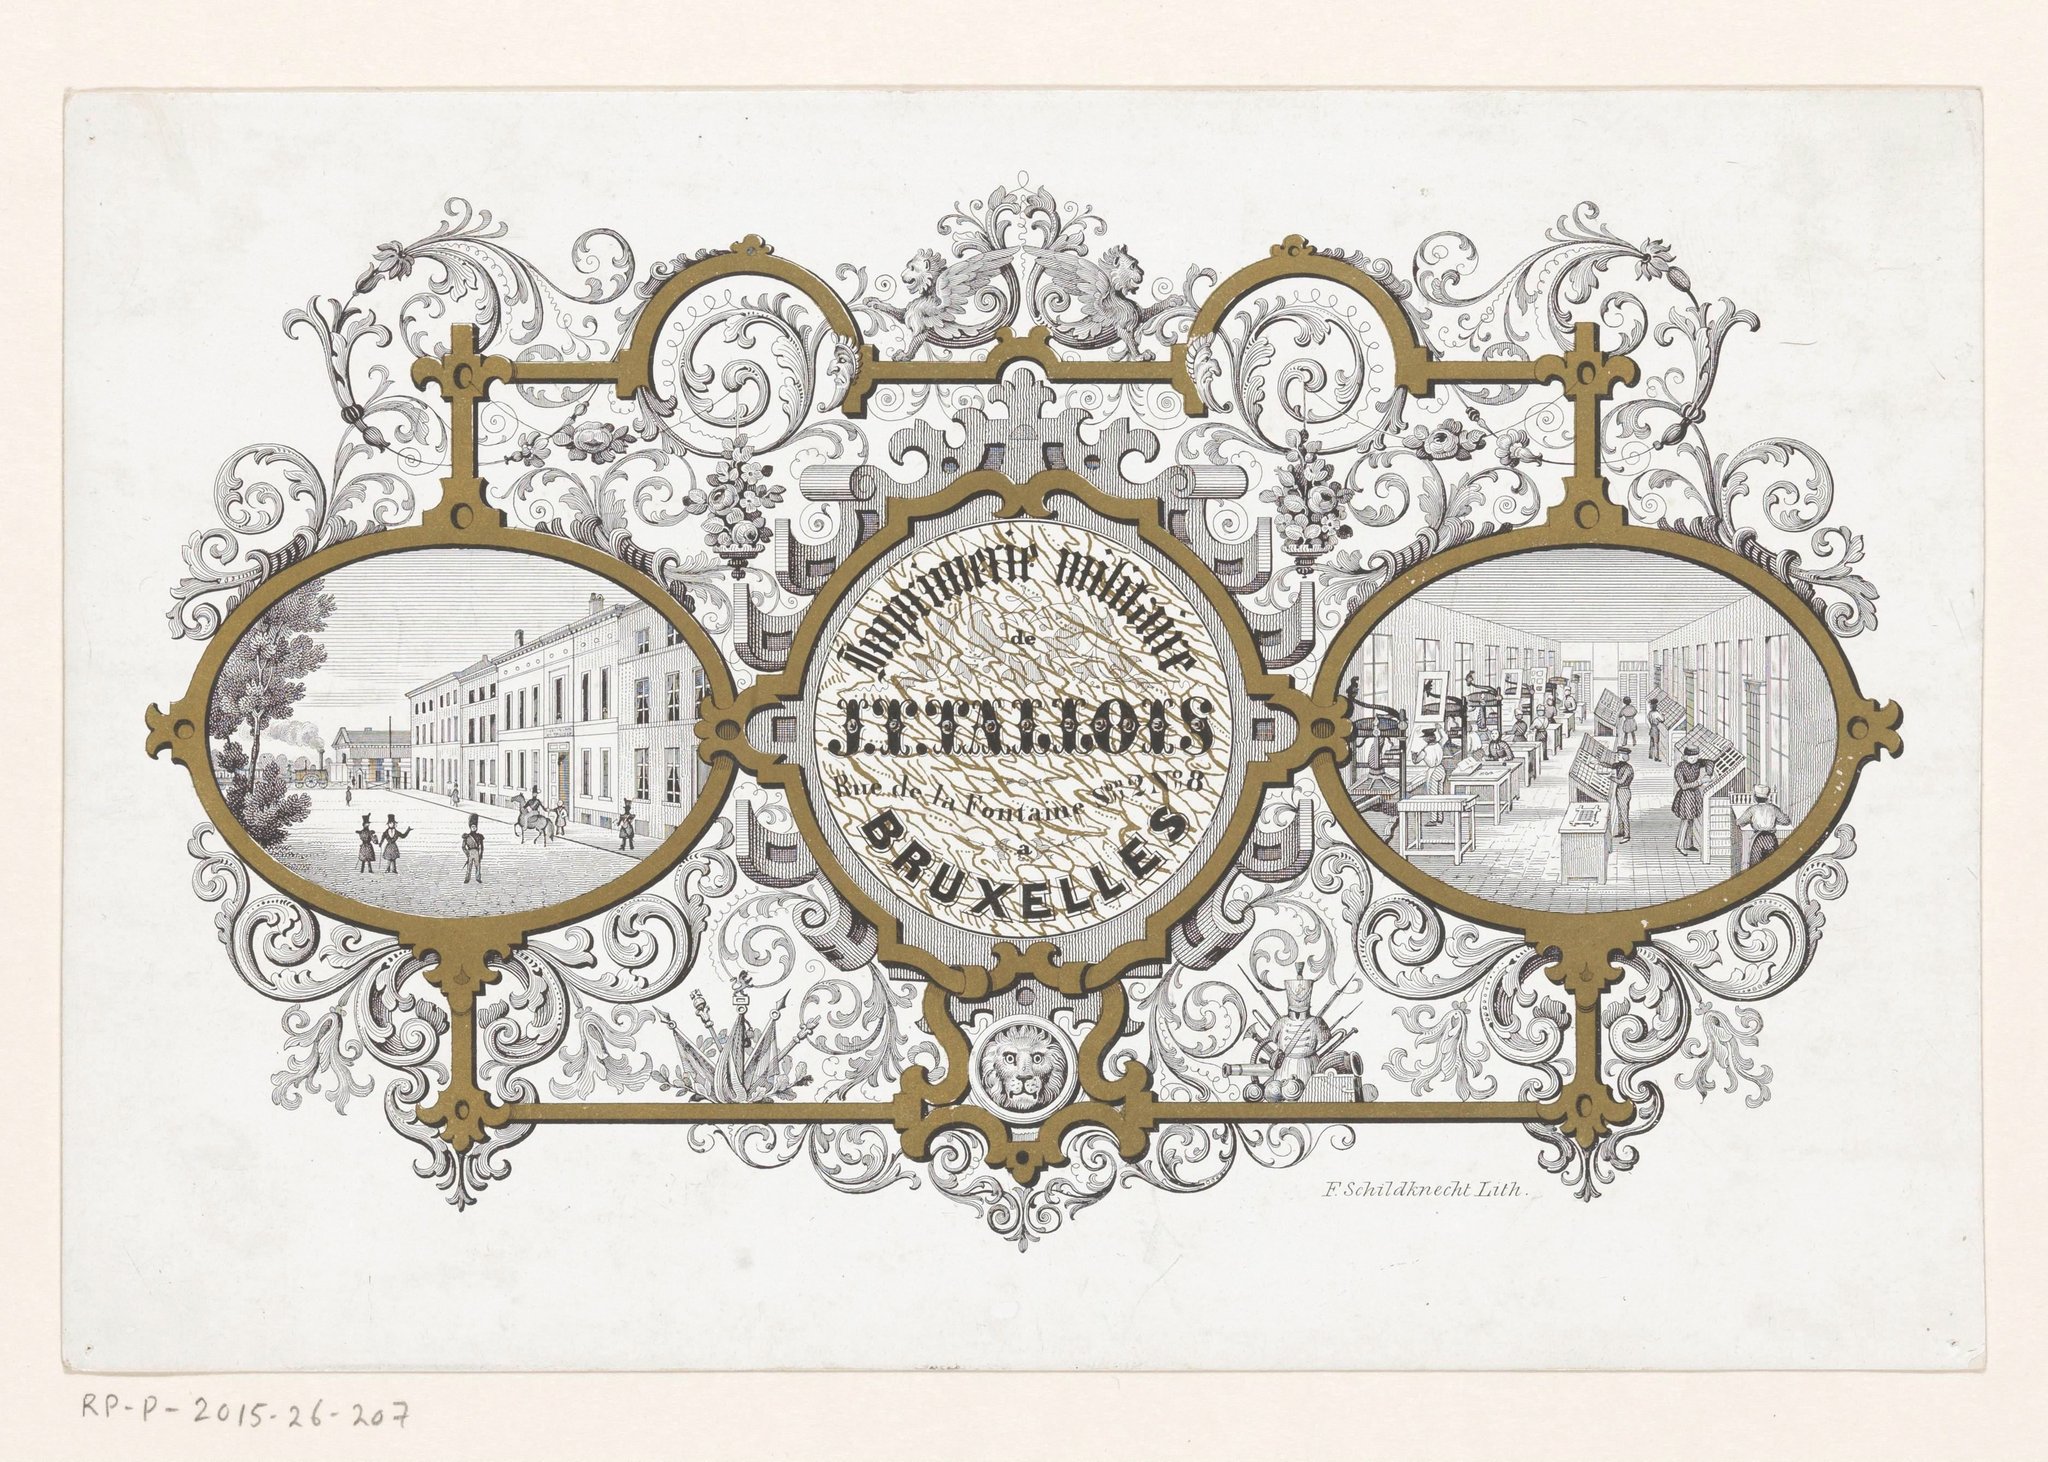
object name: print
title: Visitekaartje van militaire drukkerij J.T. Tallois te Brussel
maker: f. schildknecht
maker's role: print maker, printer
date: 1842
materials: porcelainized cardboard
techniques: lithograph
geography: brussels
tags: printing press, railway, train, brussels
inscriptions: collector's mark: Lugt 4780, collector's mark: Lugt 2228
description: Ornamentele omlijsting met militaire attributen. Links een straatgezicht met in de achtergrond een treinstation, mogelijk de Rue de la Fontaine te Brussel. Rechts het interieur van de militaire drukkerij met verschillende drukpersen en letterzetters.